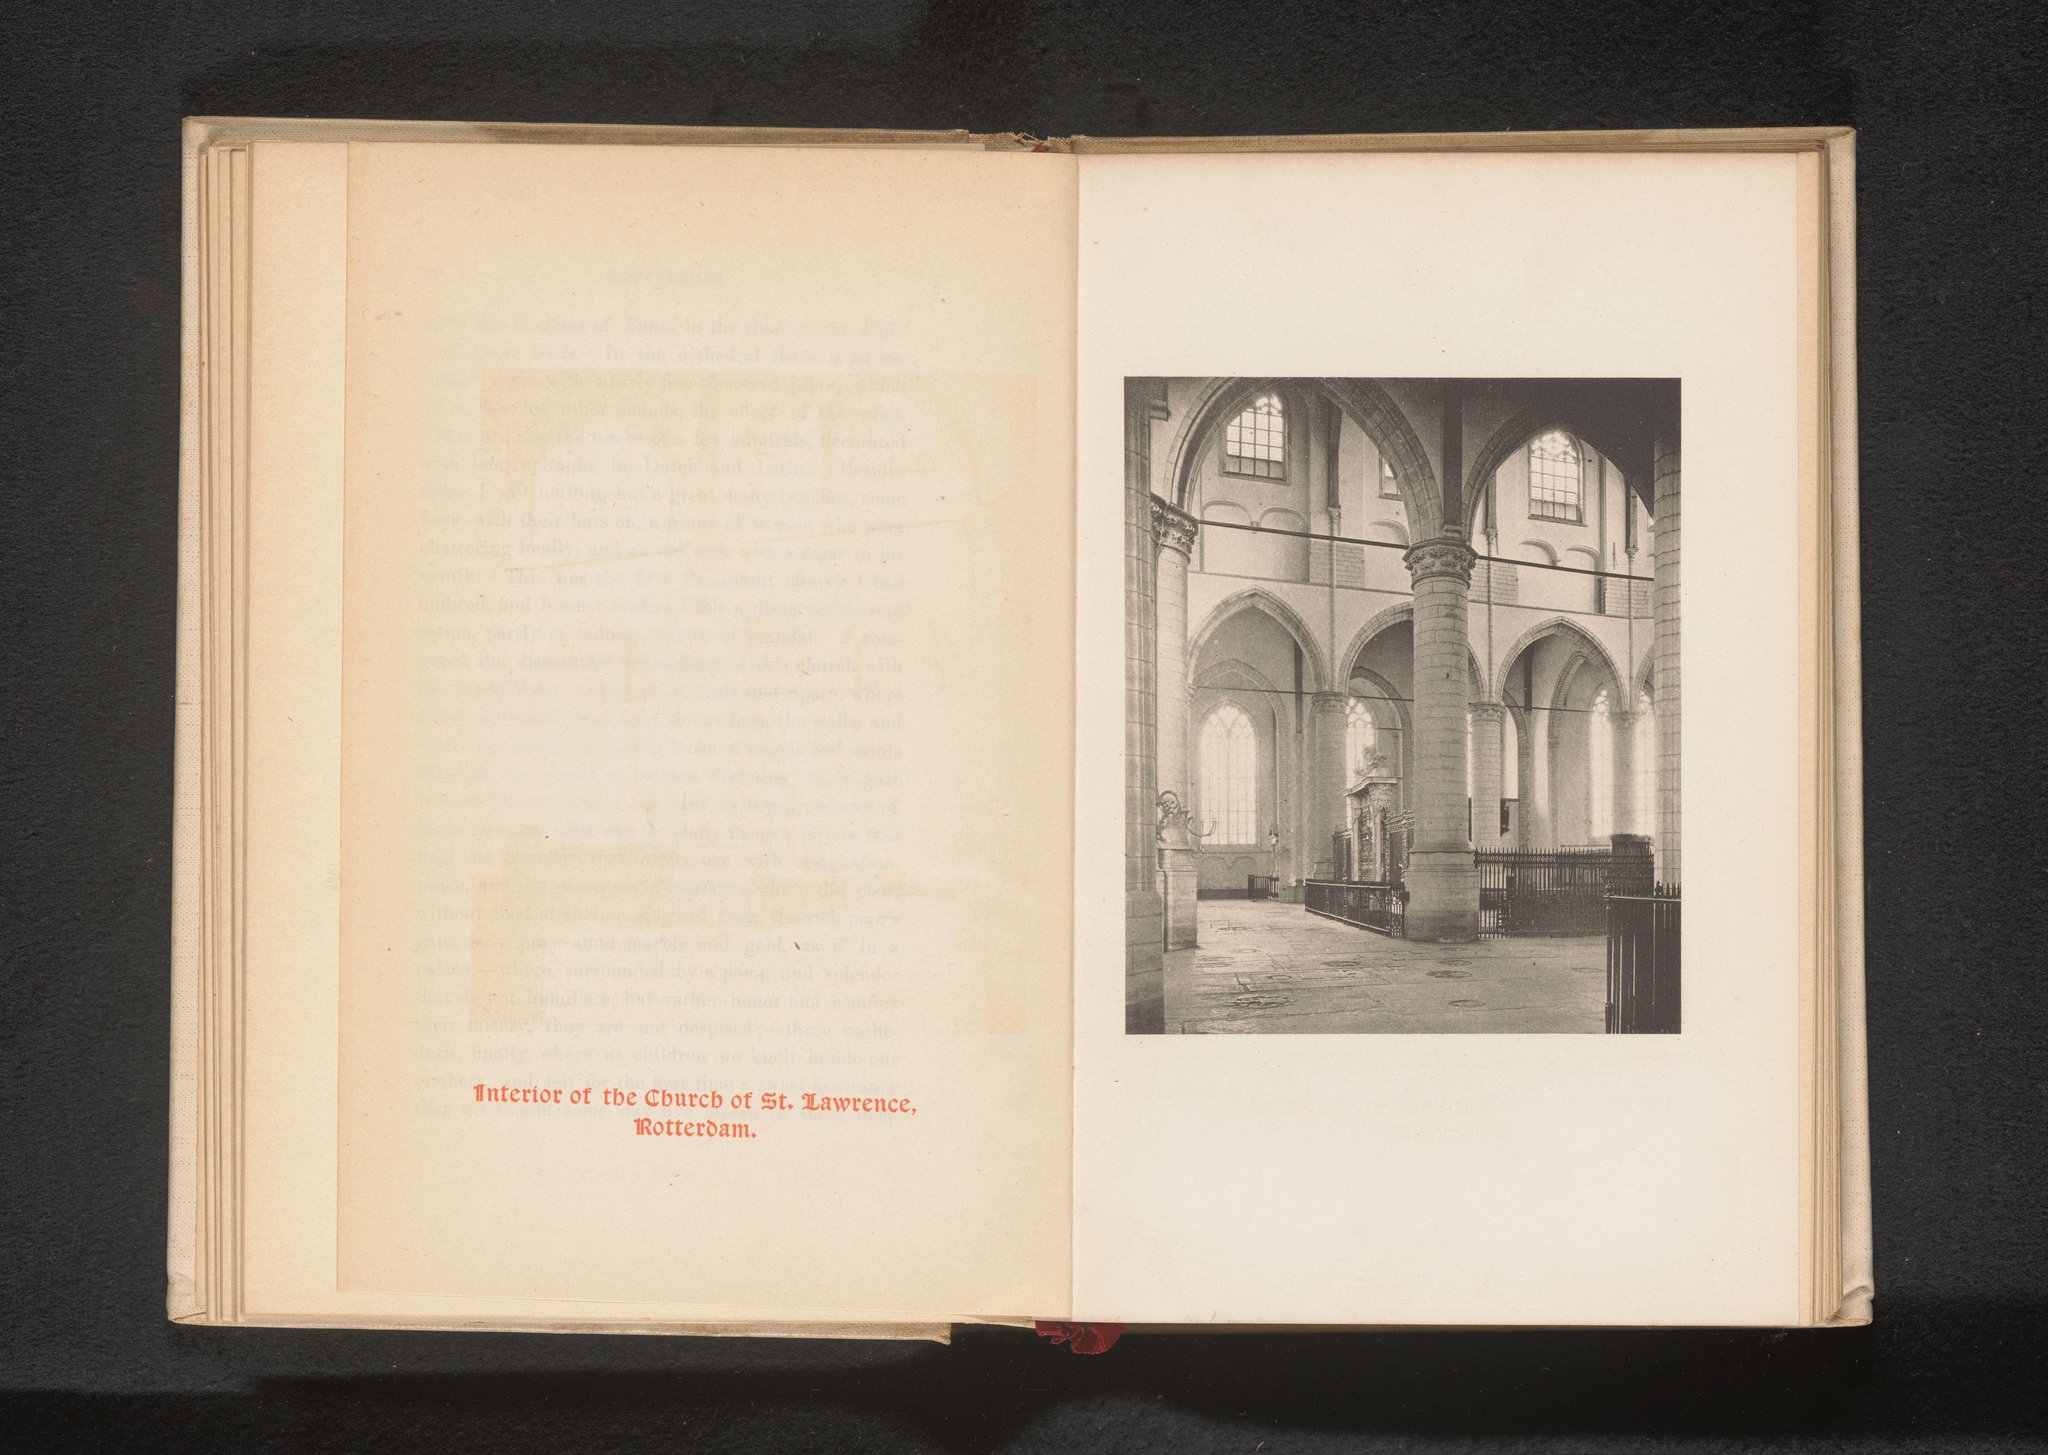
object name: photomechanical print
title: Interieur van de Sint-Laurenskerk te Rotterdam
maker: charles l. mitchell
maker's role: fotograaf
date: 1884-1894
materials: paper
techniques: photoaquatint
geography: boston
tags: interior of church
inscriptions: title: ‘Interior of the Church of St. Lawrence, Rotterdam.’